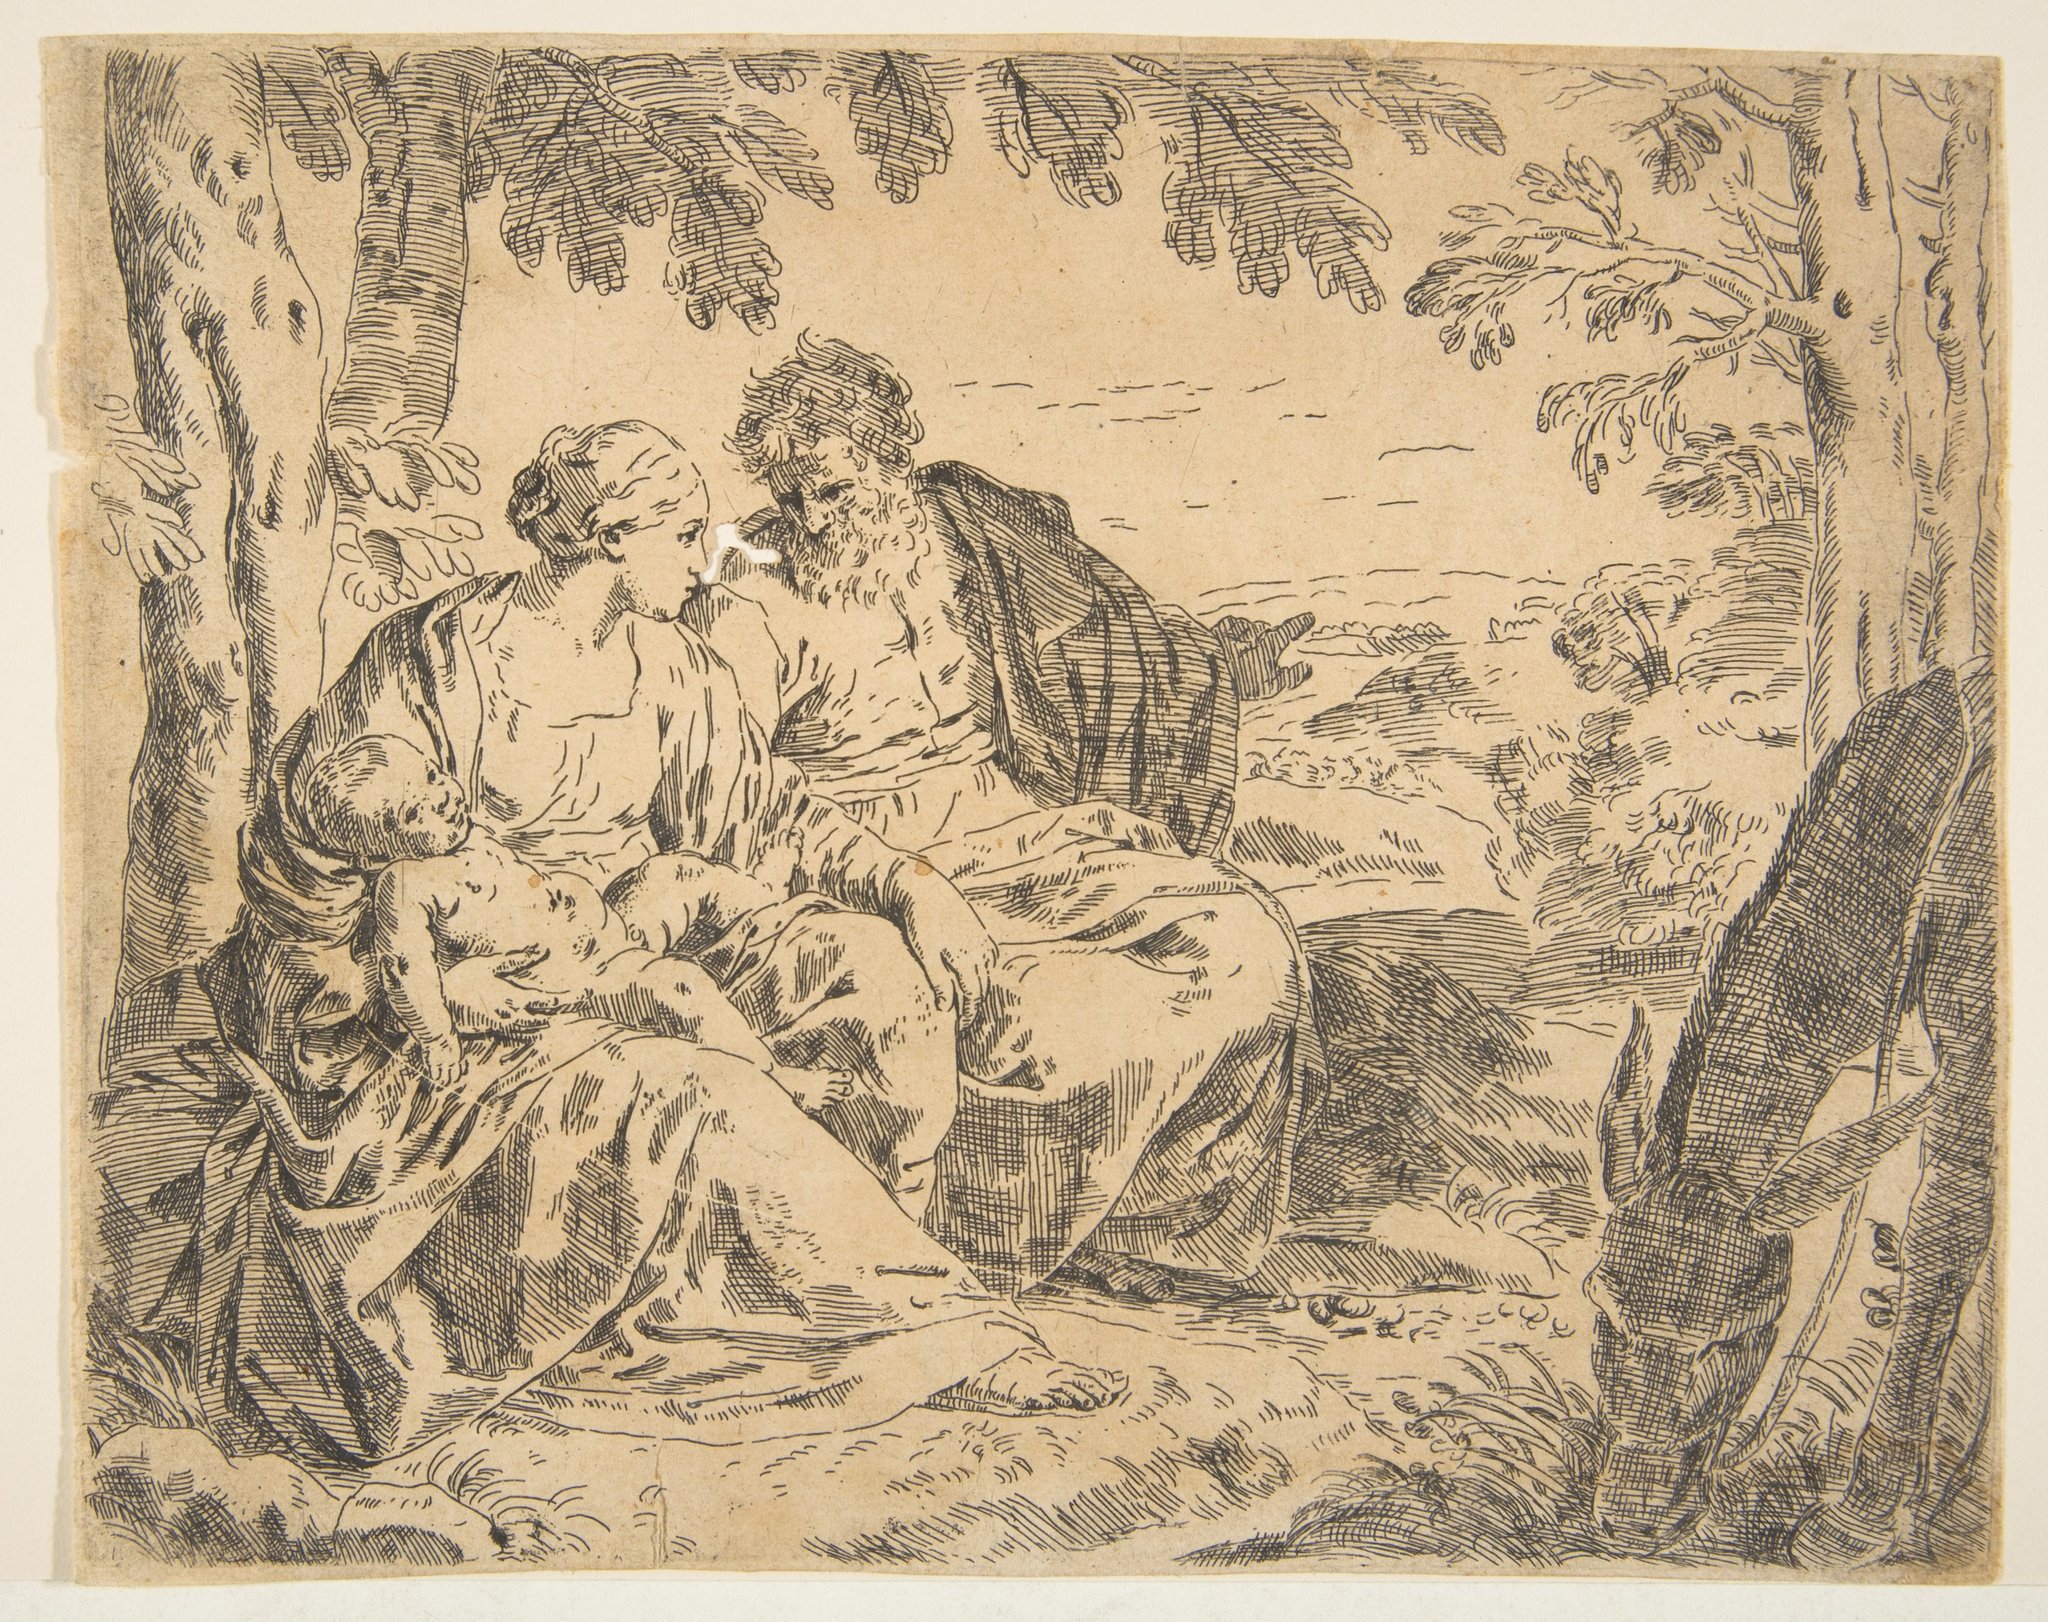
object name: print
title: Rest on the flight into Egypt, Mary holding the infant Christ while St. Joseph points into the distance, copy after Cantarini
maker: simone cantarini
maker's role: artist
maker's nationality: italian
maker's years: 1612-1648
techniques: etching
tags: infants,men,christ,virgin mary